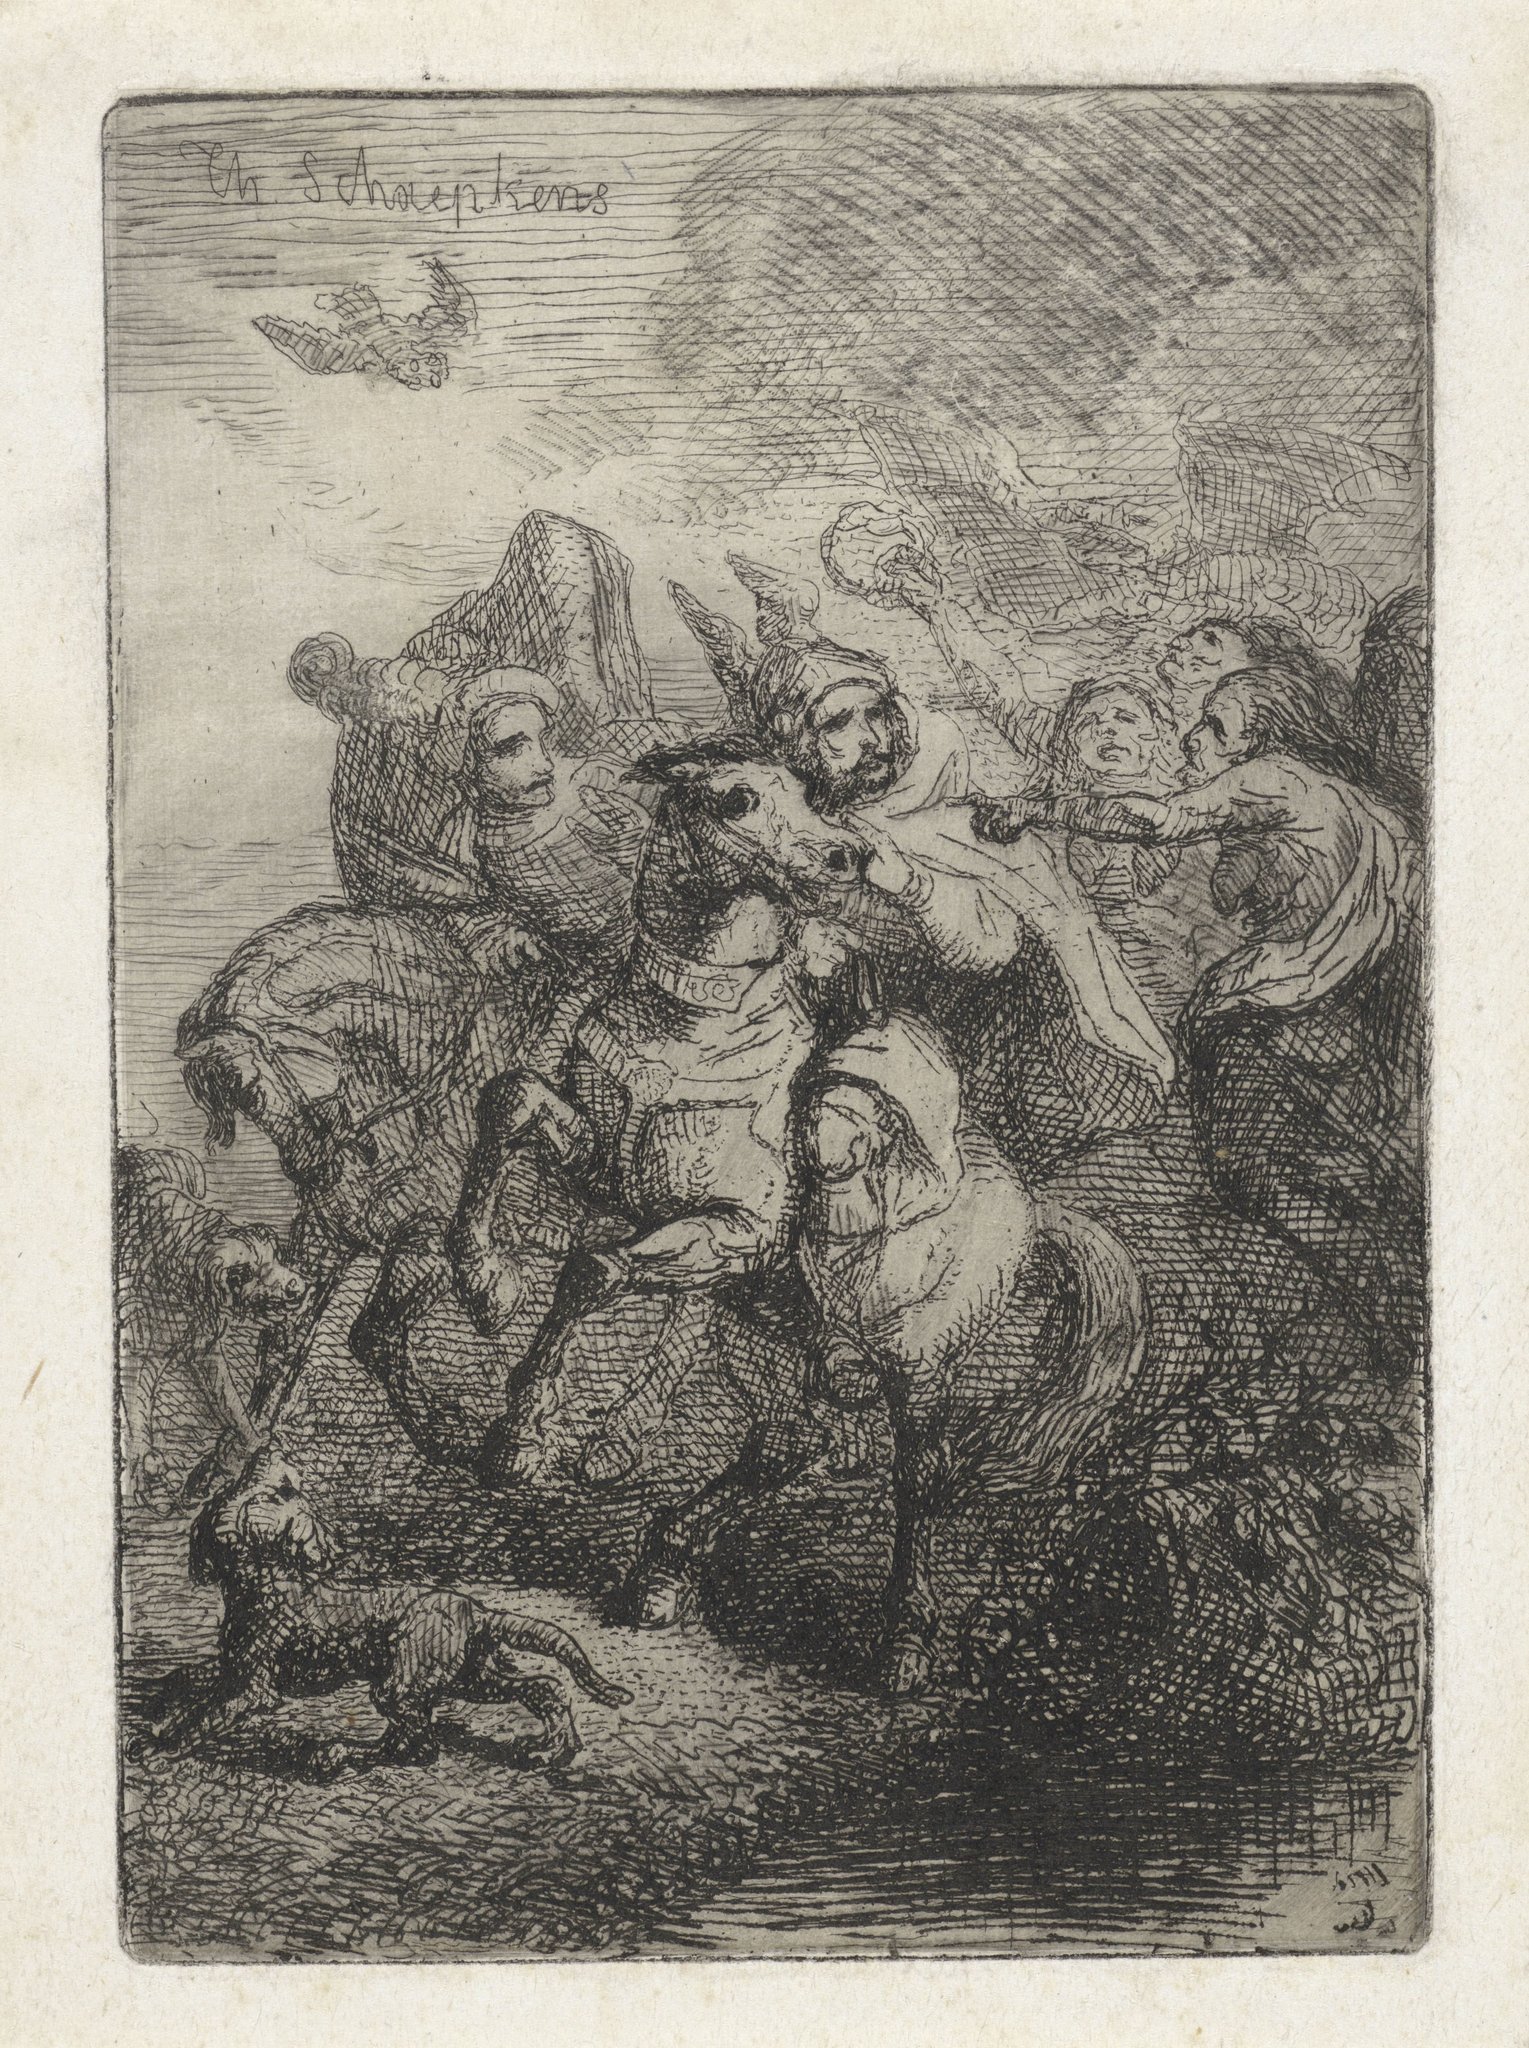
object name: print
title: Macbeth en Banquo ontmoeten de drie heksen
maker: theodoor schaepkens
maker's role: draughtsman, print maker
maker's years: 1810-1883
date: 1825-1883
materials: paper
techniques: drypoint, etching, roulette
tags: macbeth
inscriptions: collector's mark: Lugt 2228